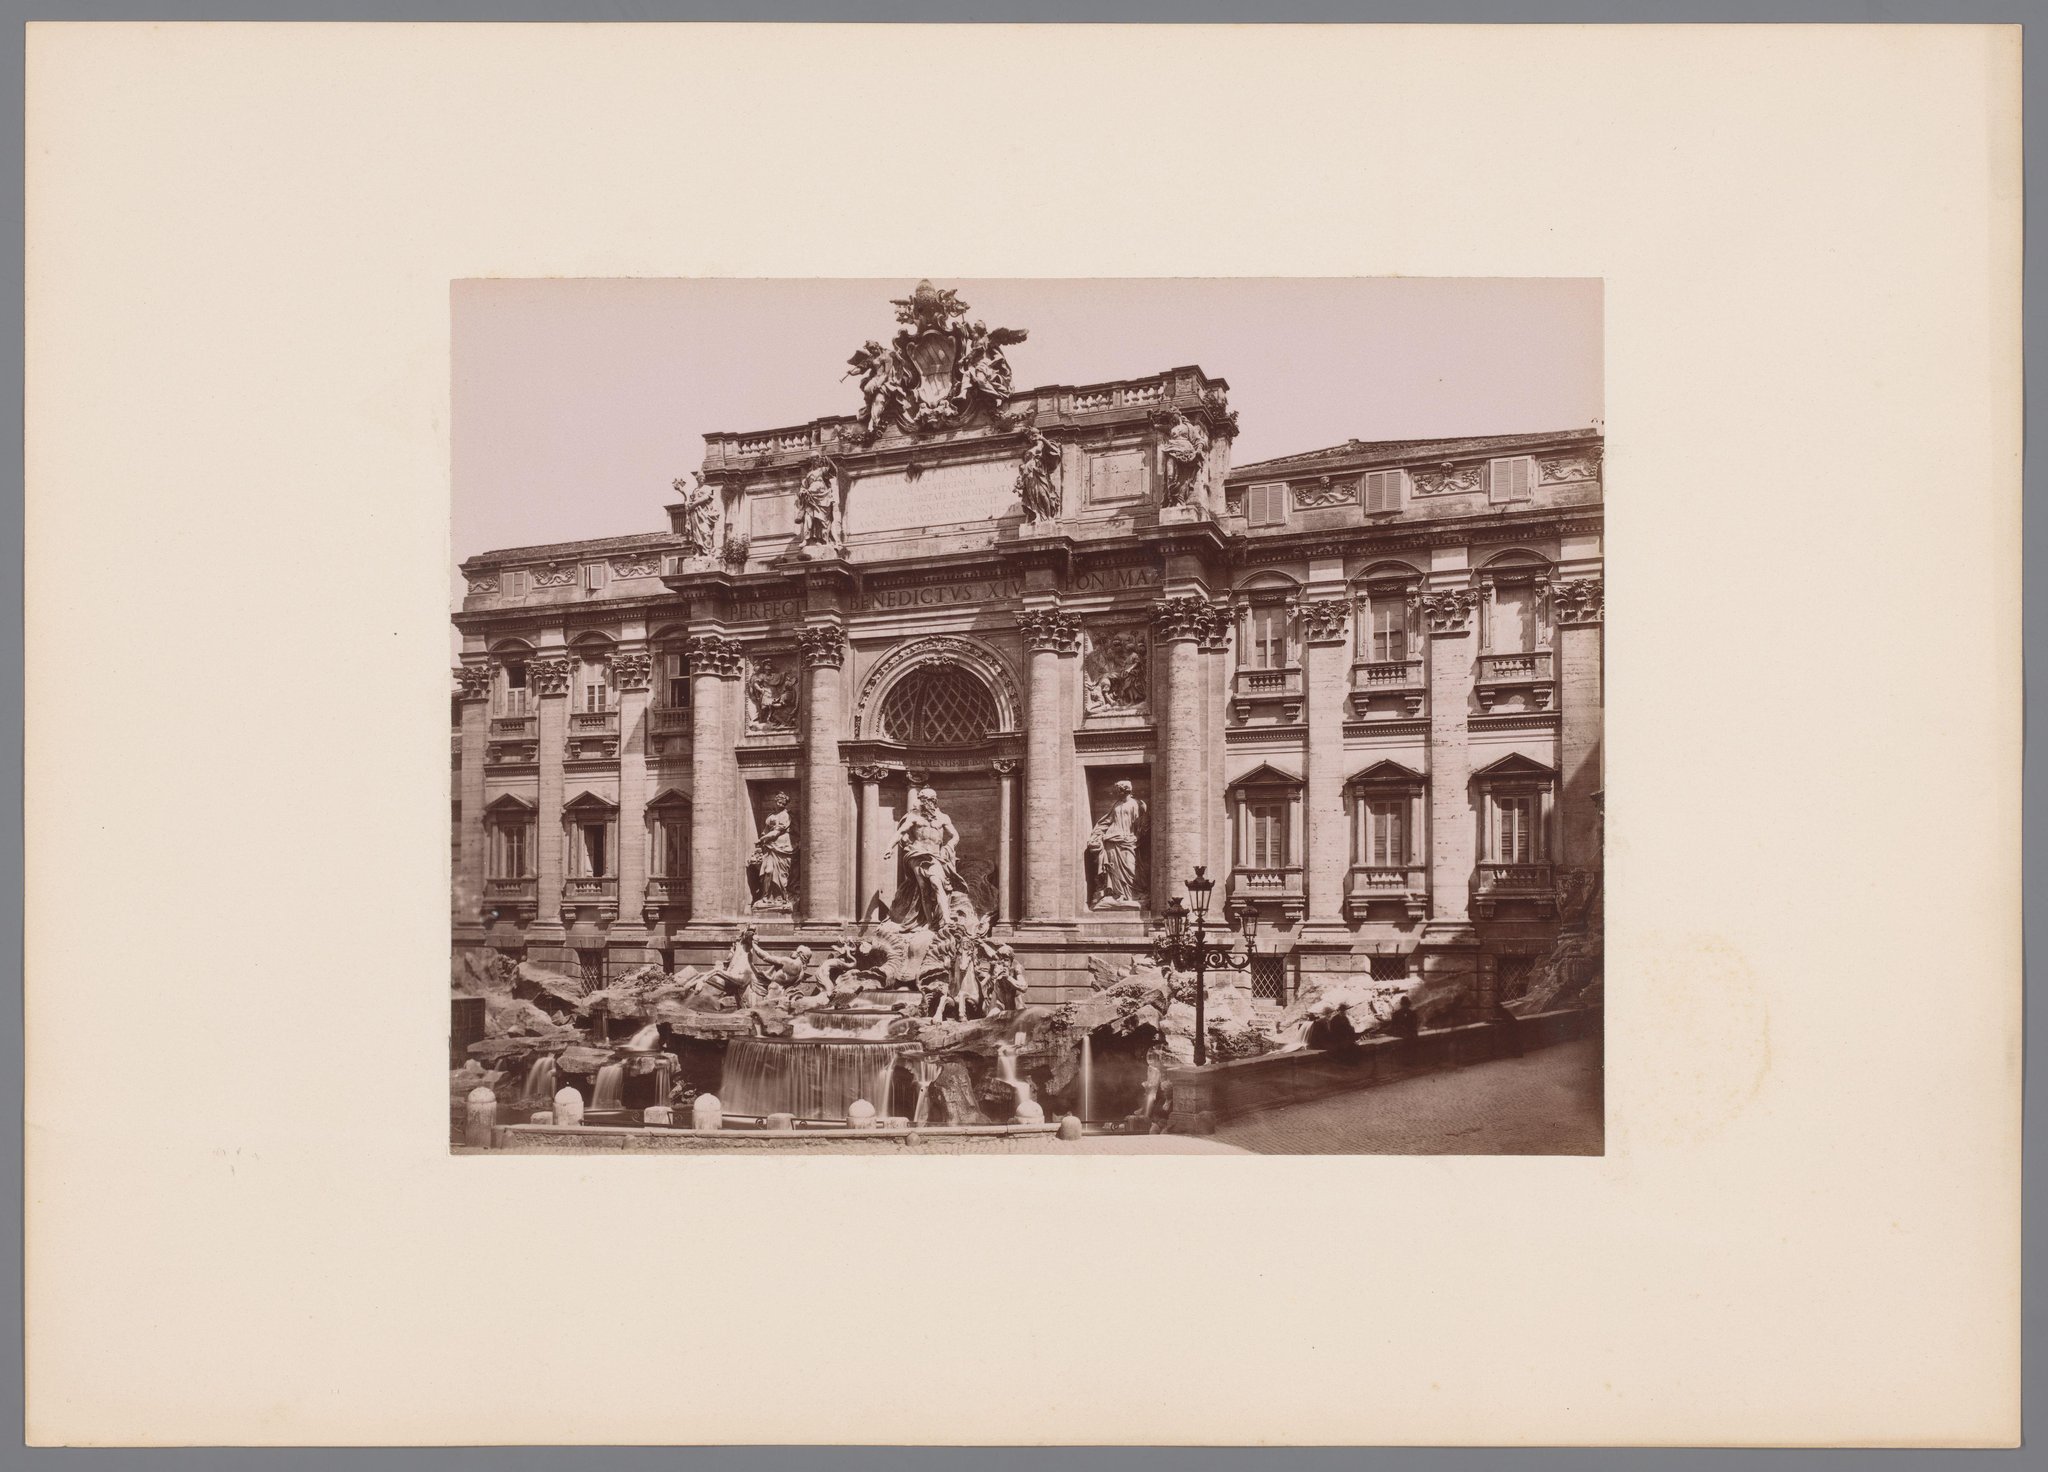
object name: photograph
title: Trevifontein te Rome, Italië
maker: Anonymous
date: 1851-1900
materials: cardboard, paper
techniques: albumen print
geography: rome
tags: ornamental fountain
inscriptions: number: ‘60,’